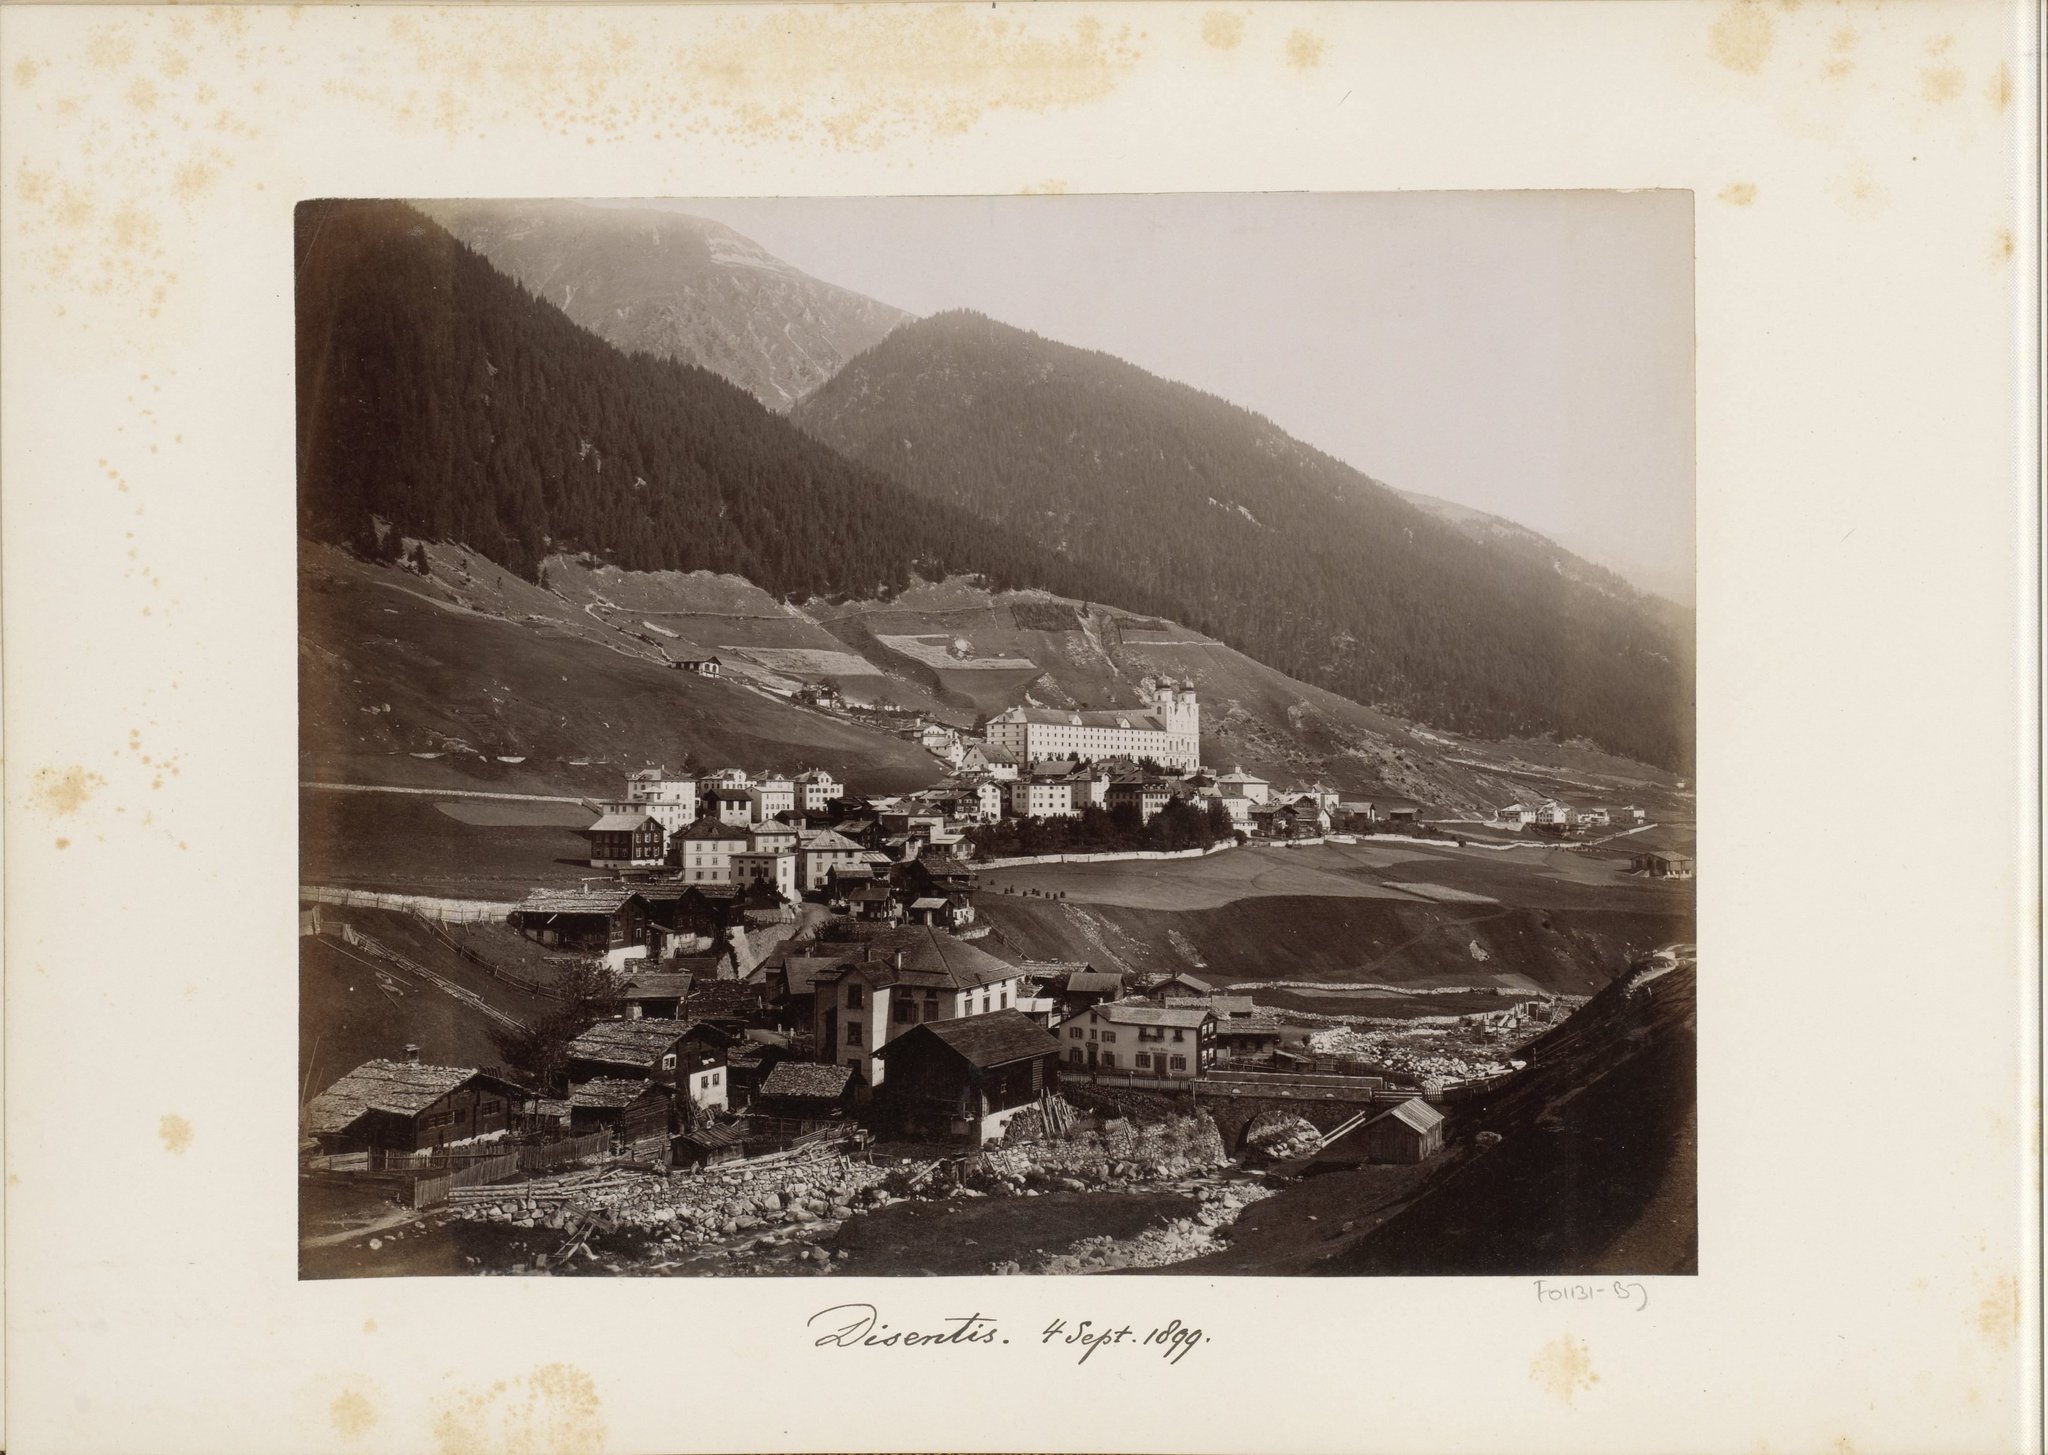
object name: album leaf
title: Gezicht op Disentis-Mustér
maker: Anonymous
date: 1880-1899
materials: paper, photographic support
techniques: albumen print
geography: disentis-mustér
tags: prospect of village, silhouette of village, mountains (+ landscape with figures, staffage)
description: Onderdeel van Reisalbum met bezienswaardigheden in Duitsland, Oostenrijk, Zwitserland, Luxemburg en België.